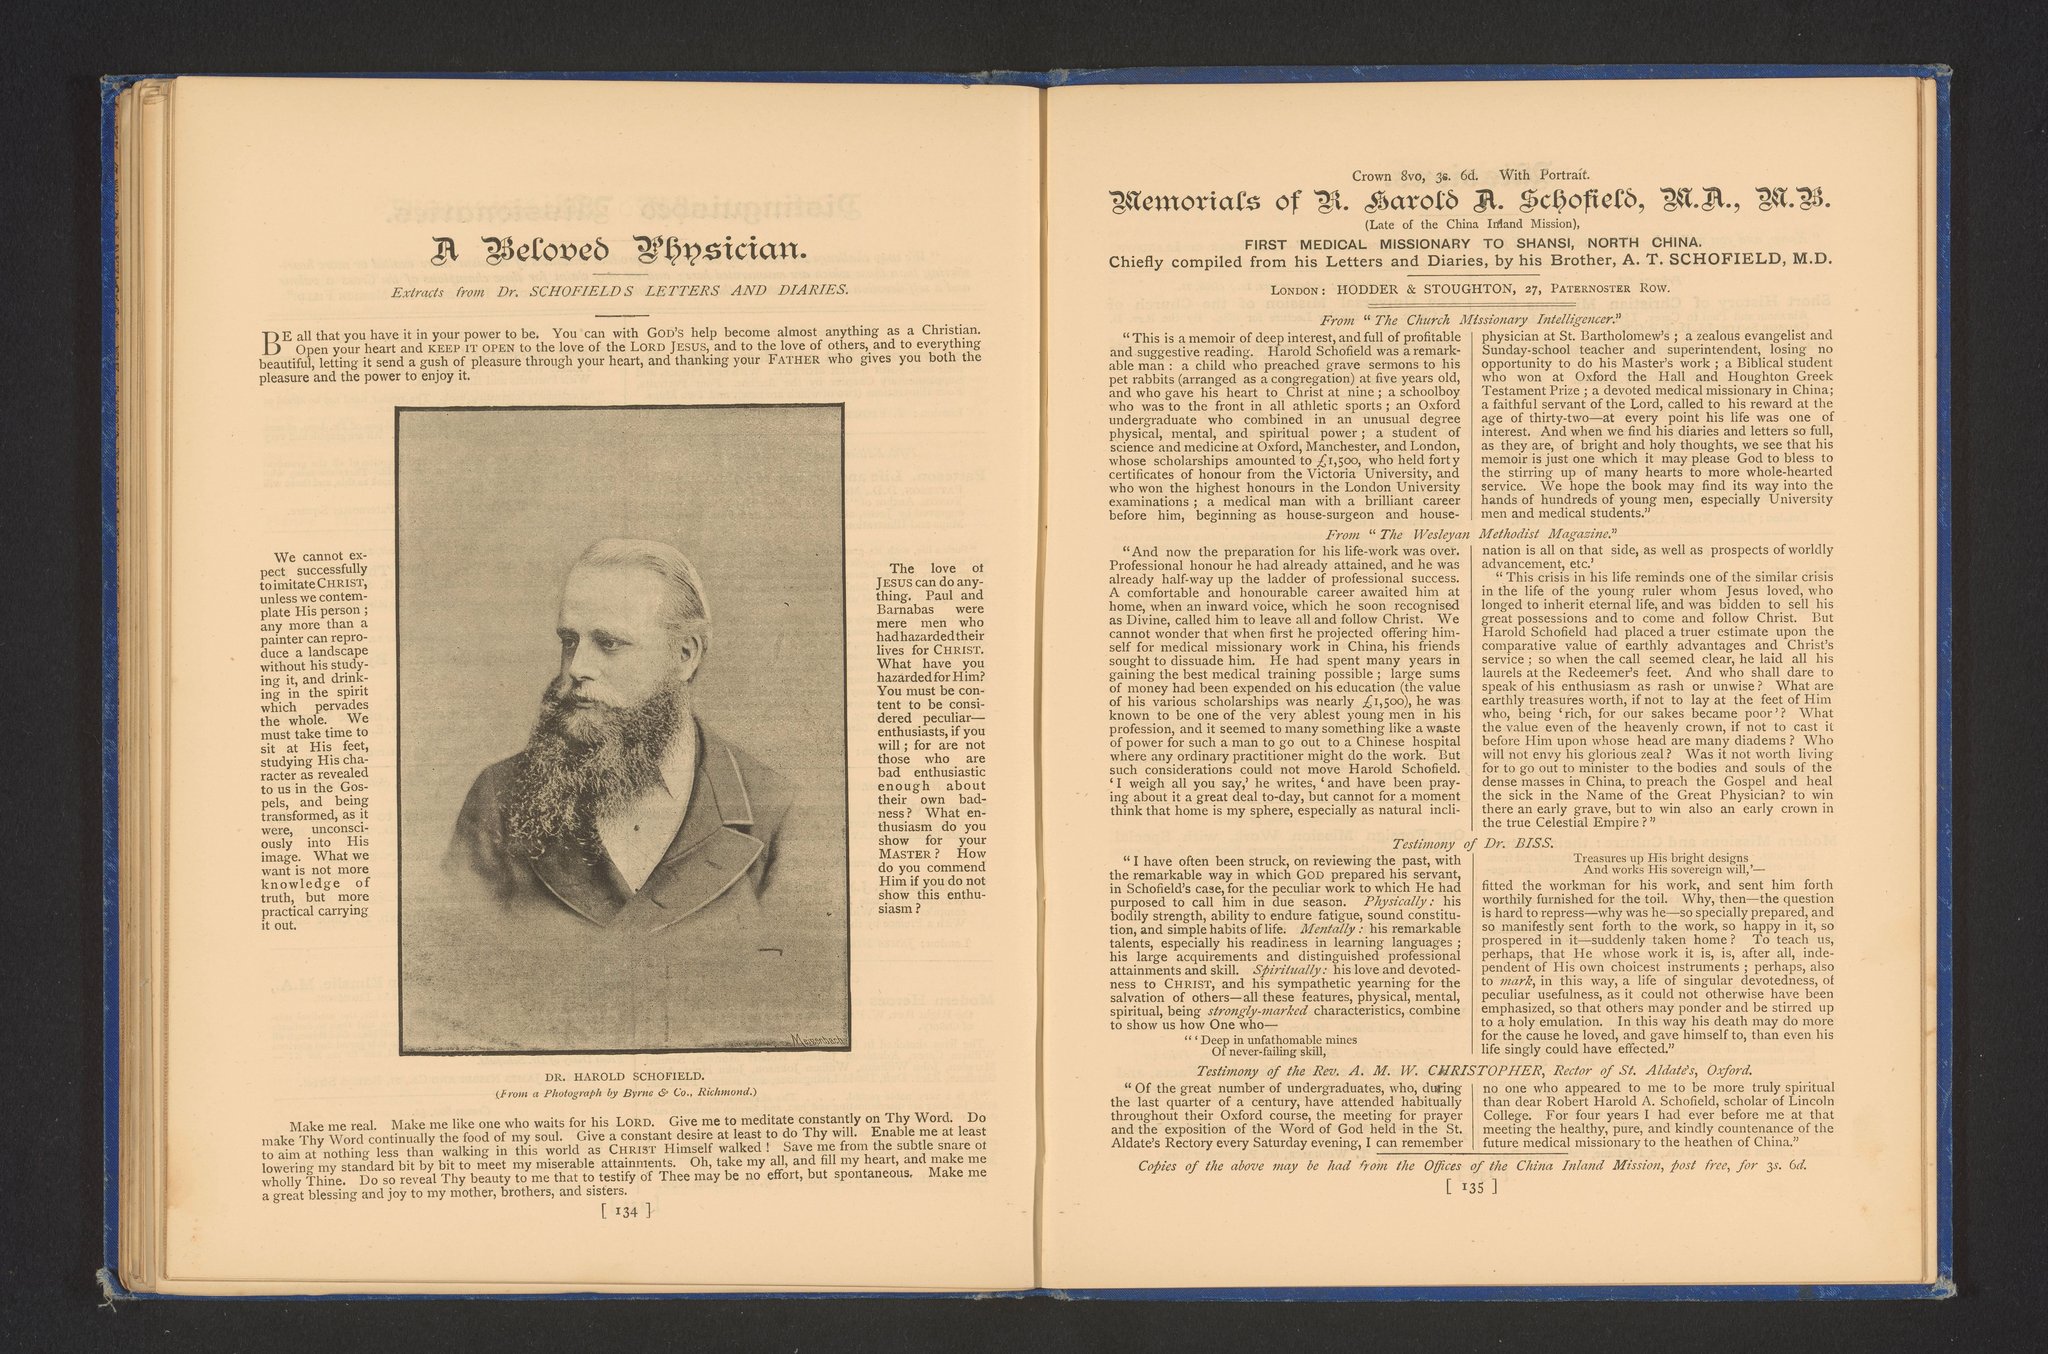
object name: page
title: Dr. Harold Schofield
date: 1881-1883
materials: paper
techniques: autotype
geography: richmond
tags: missionary, historical persons, spreading the gospel; missionary work